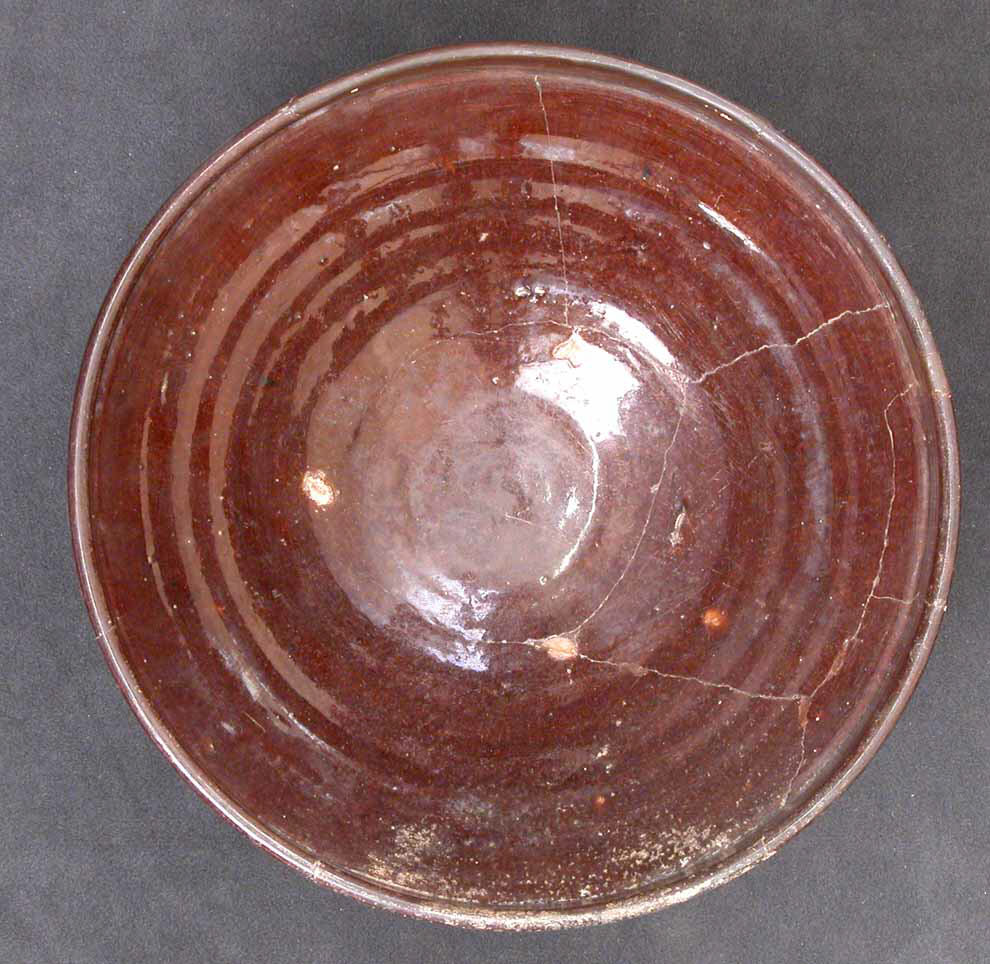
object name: bowl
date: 801-1100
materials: earthenware, glaze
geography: iran